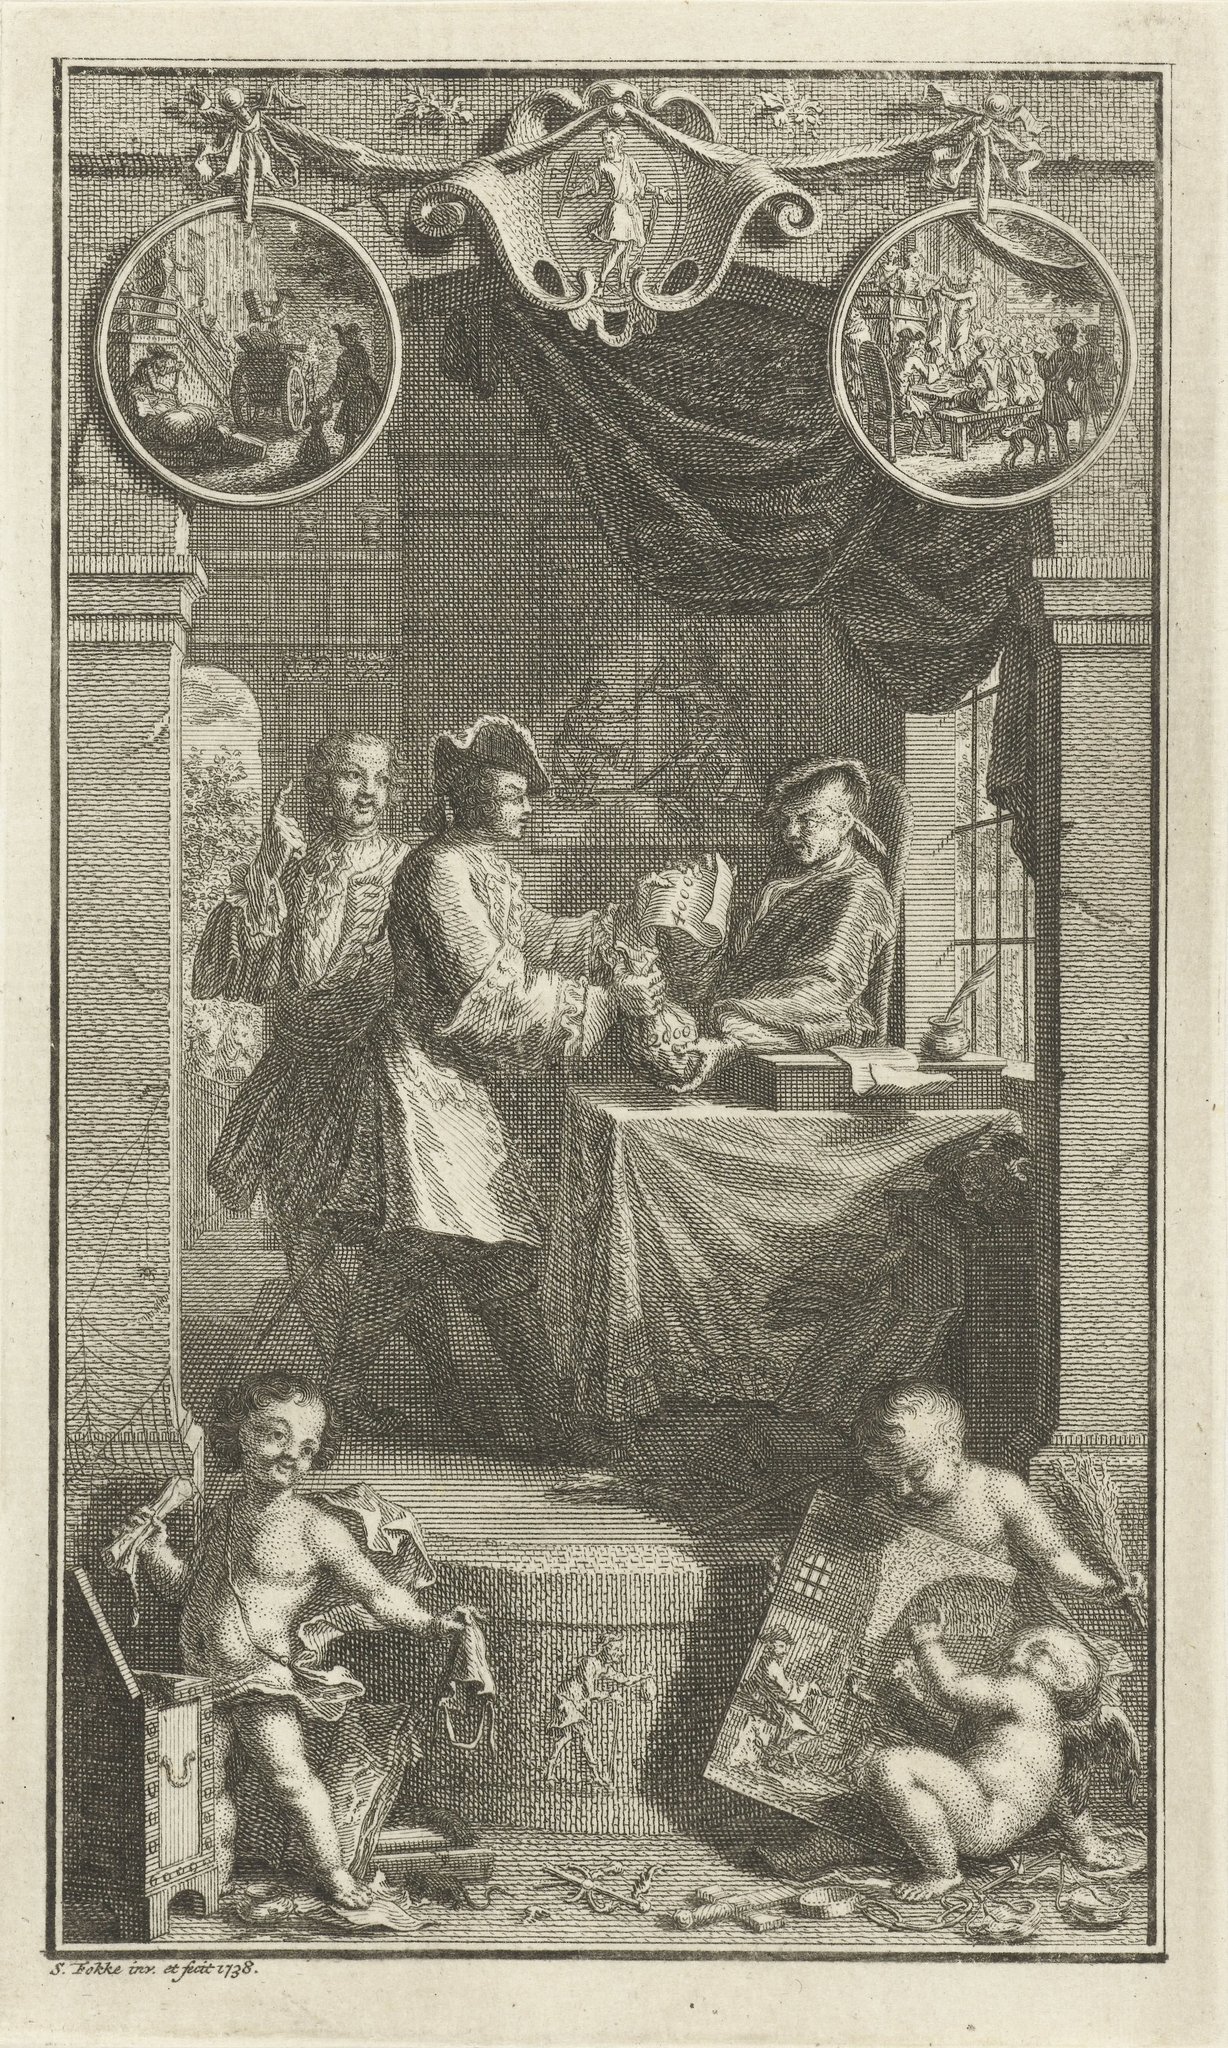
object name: print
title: Allegorie op het bedrog van Aron Abrams, 1737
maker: simon fokke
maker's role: draughtsman, print maker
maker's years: 1712-1784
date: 1738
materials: paper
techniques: engraving, etching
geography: northern netherlands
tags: fraudulence, swindling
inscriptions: collector's mark: Lugt 2228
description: Allegorie op het bedrog van de Amsterdamse joodse woekeraar Aron Abrams (of Abrahams). Een man overhandigt een zak geld waarop 2600 staat en ontvangt daarvoor een wissel van 4000. Deze centrale voorstelling omringd door enkele kleinere scènes.